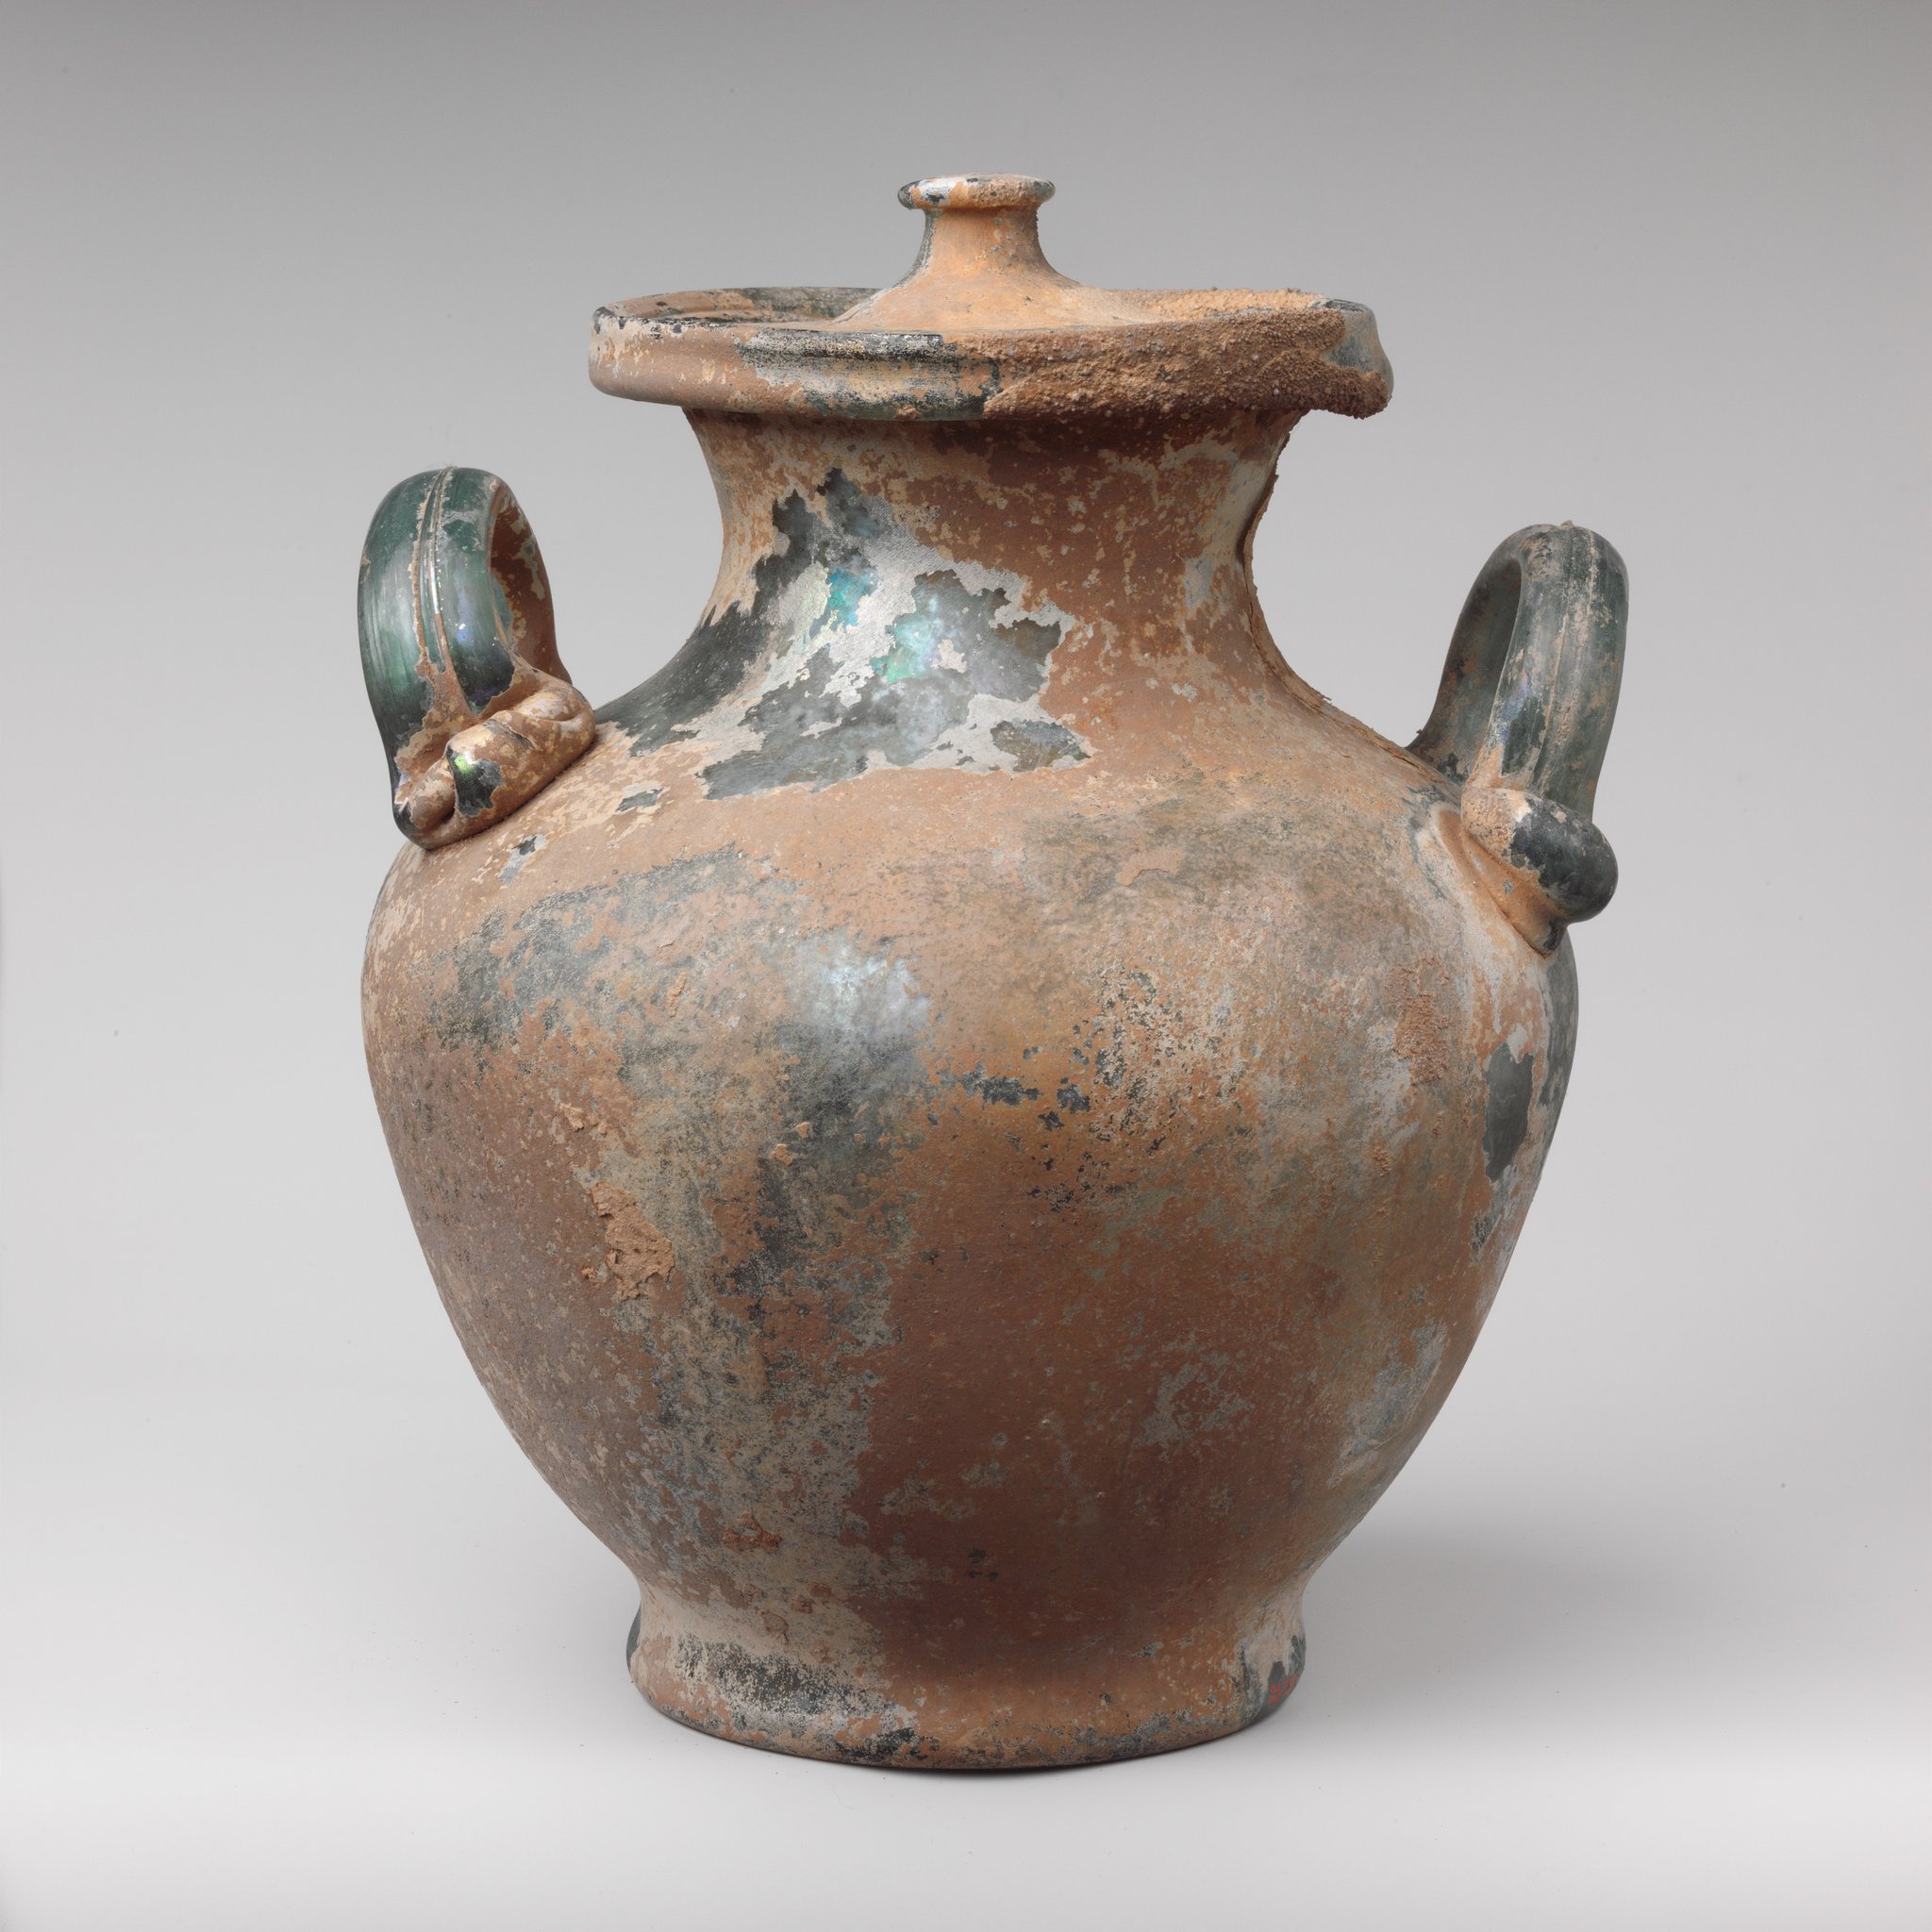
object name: urn with two handle and lid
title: Glass cinerary urn with lid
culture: roman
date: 1-133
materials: glass